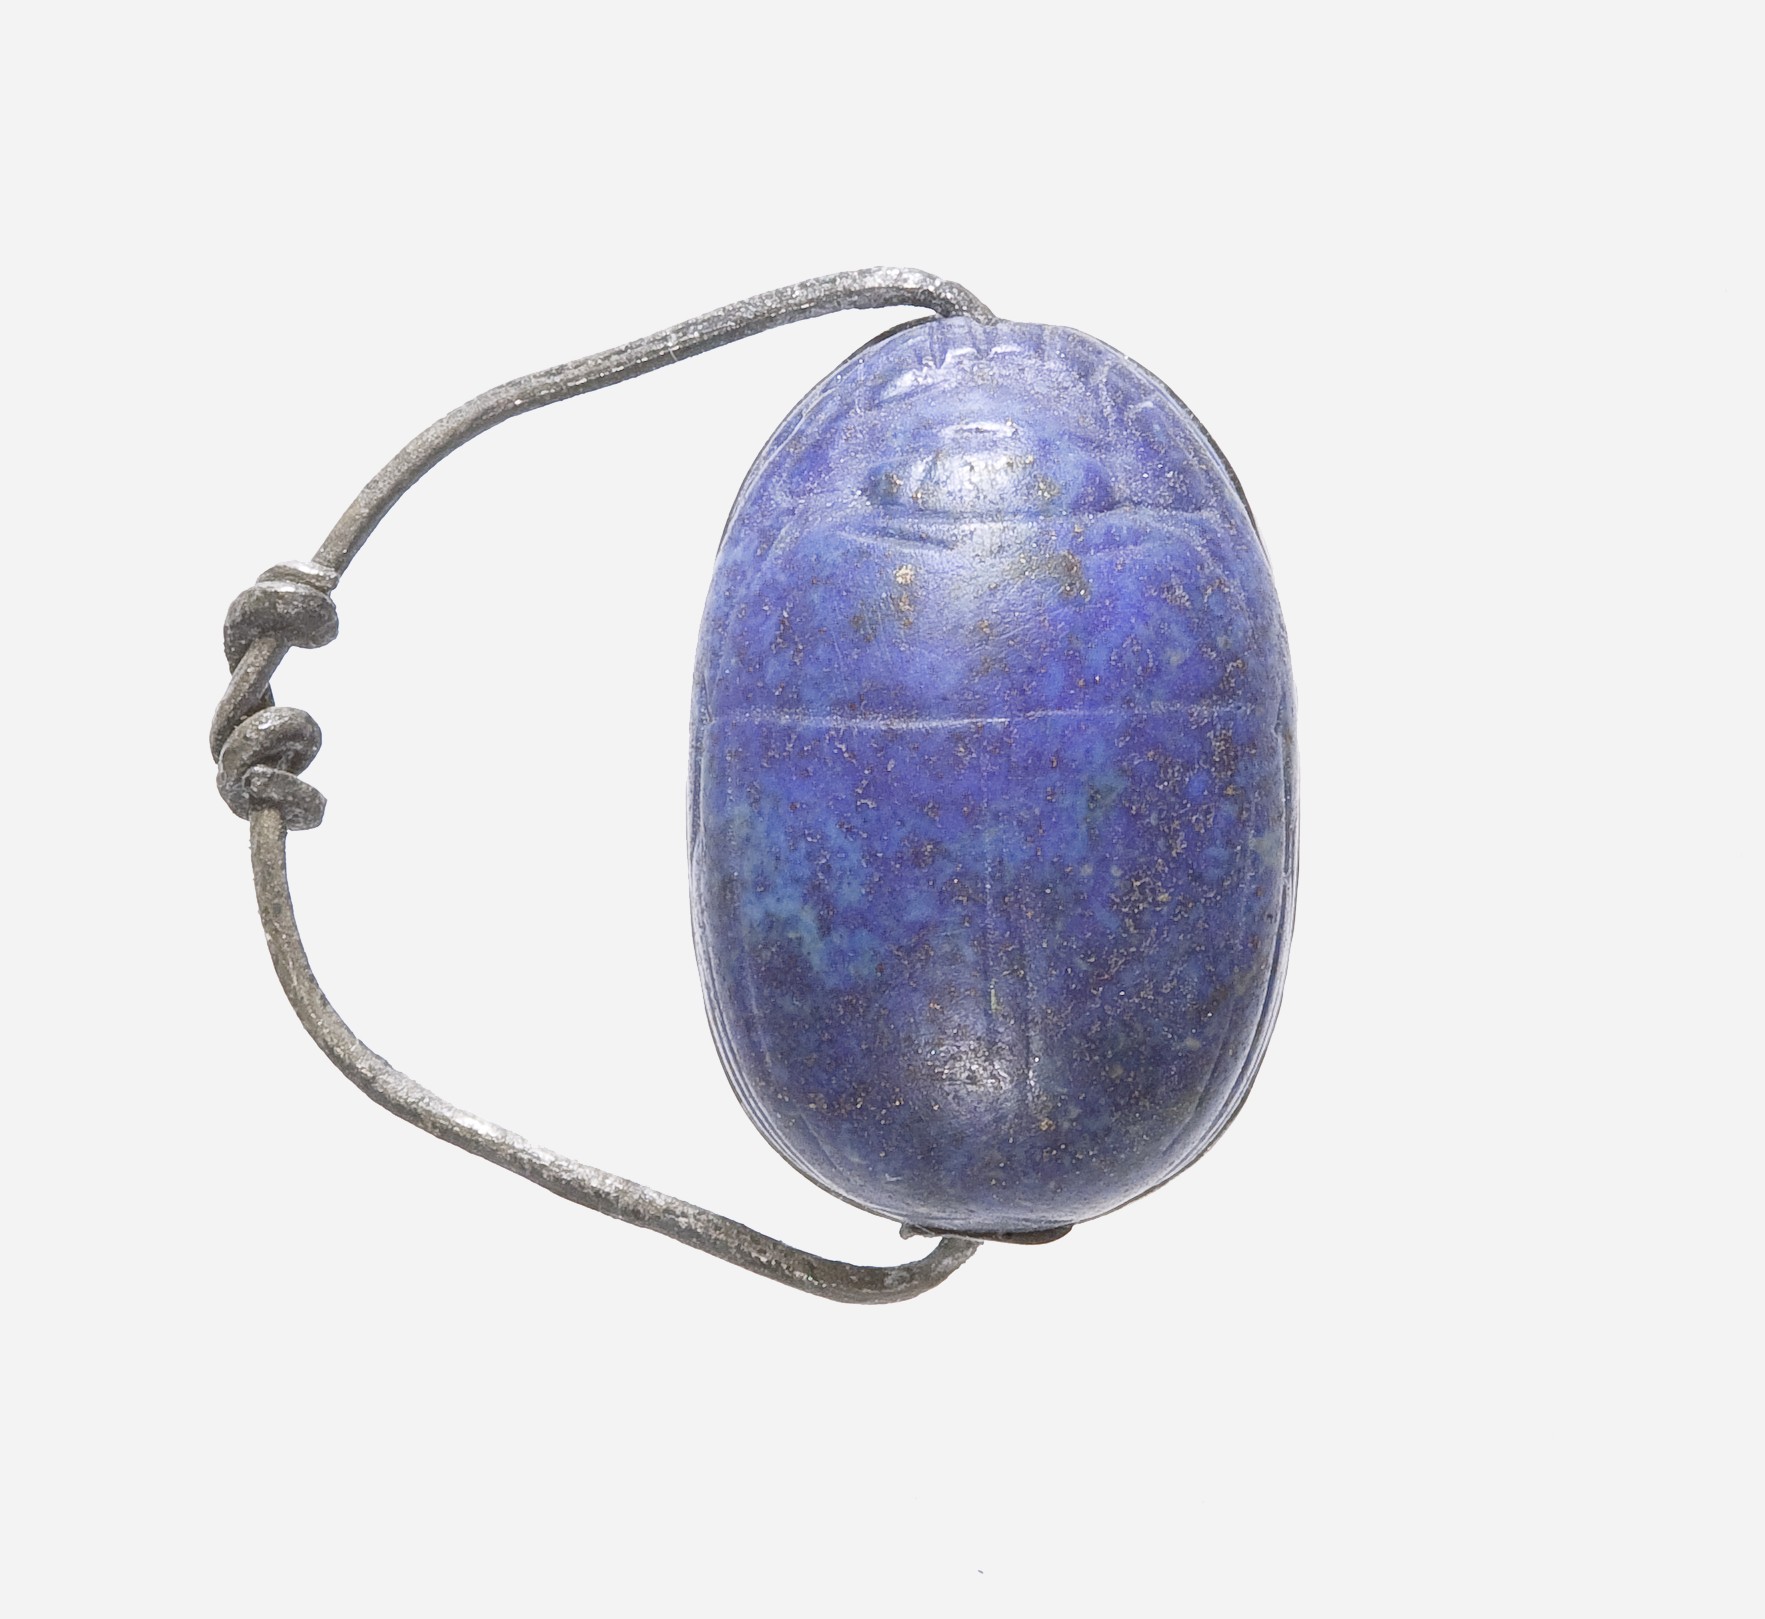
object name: scarab with remains of ring wire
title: Scarab Ring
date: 1850-1775 BCE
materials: lapis lazuli, silver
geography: egypt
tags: scarabs